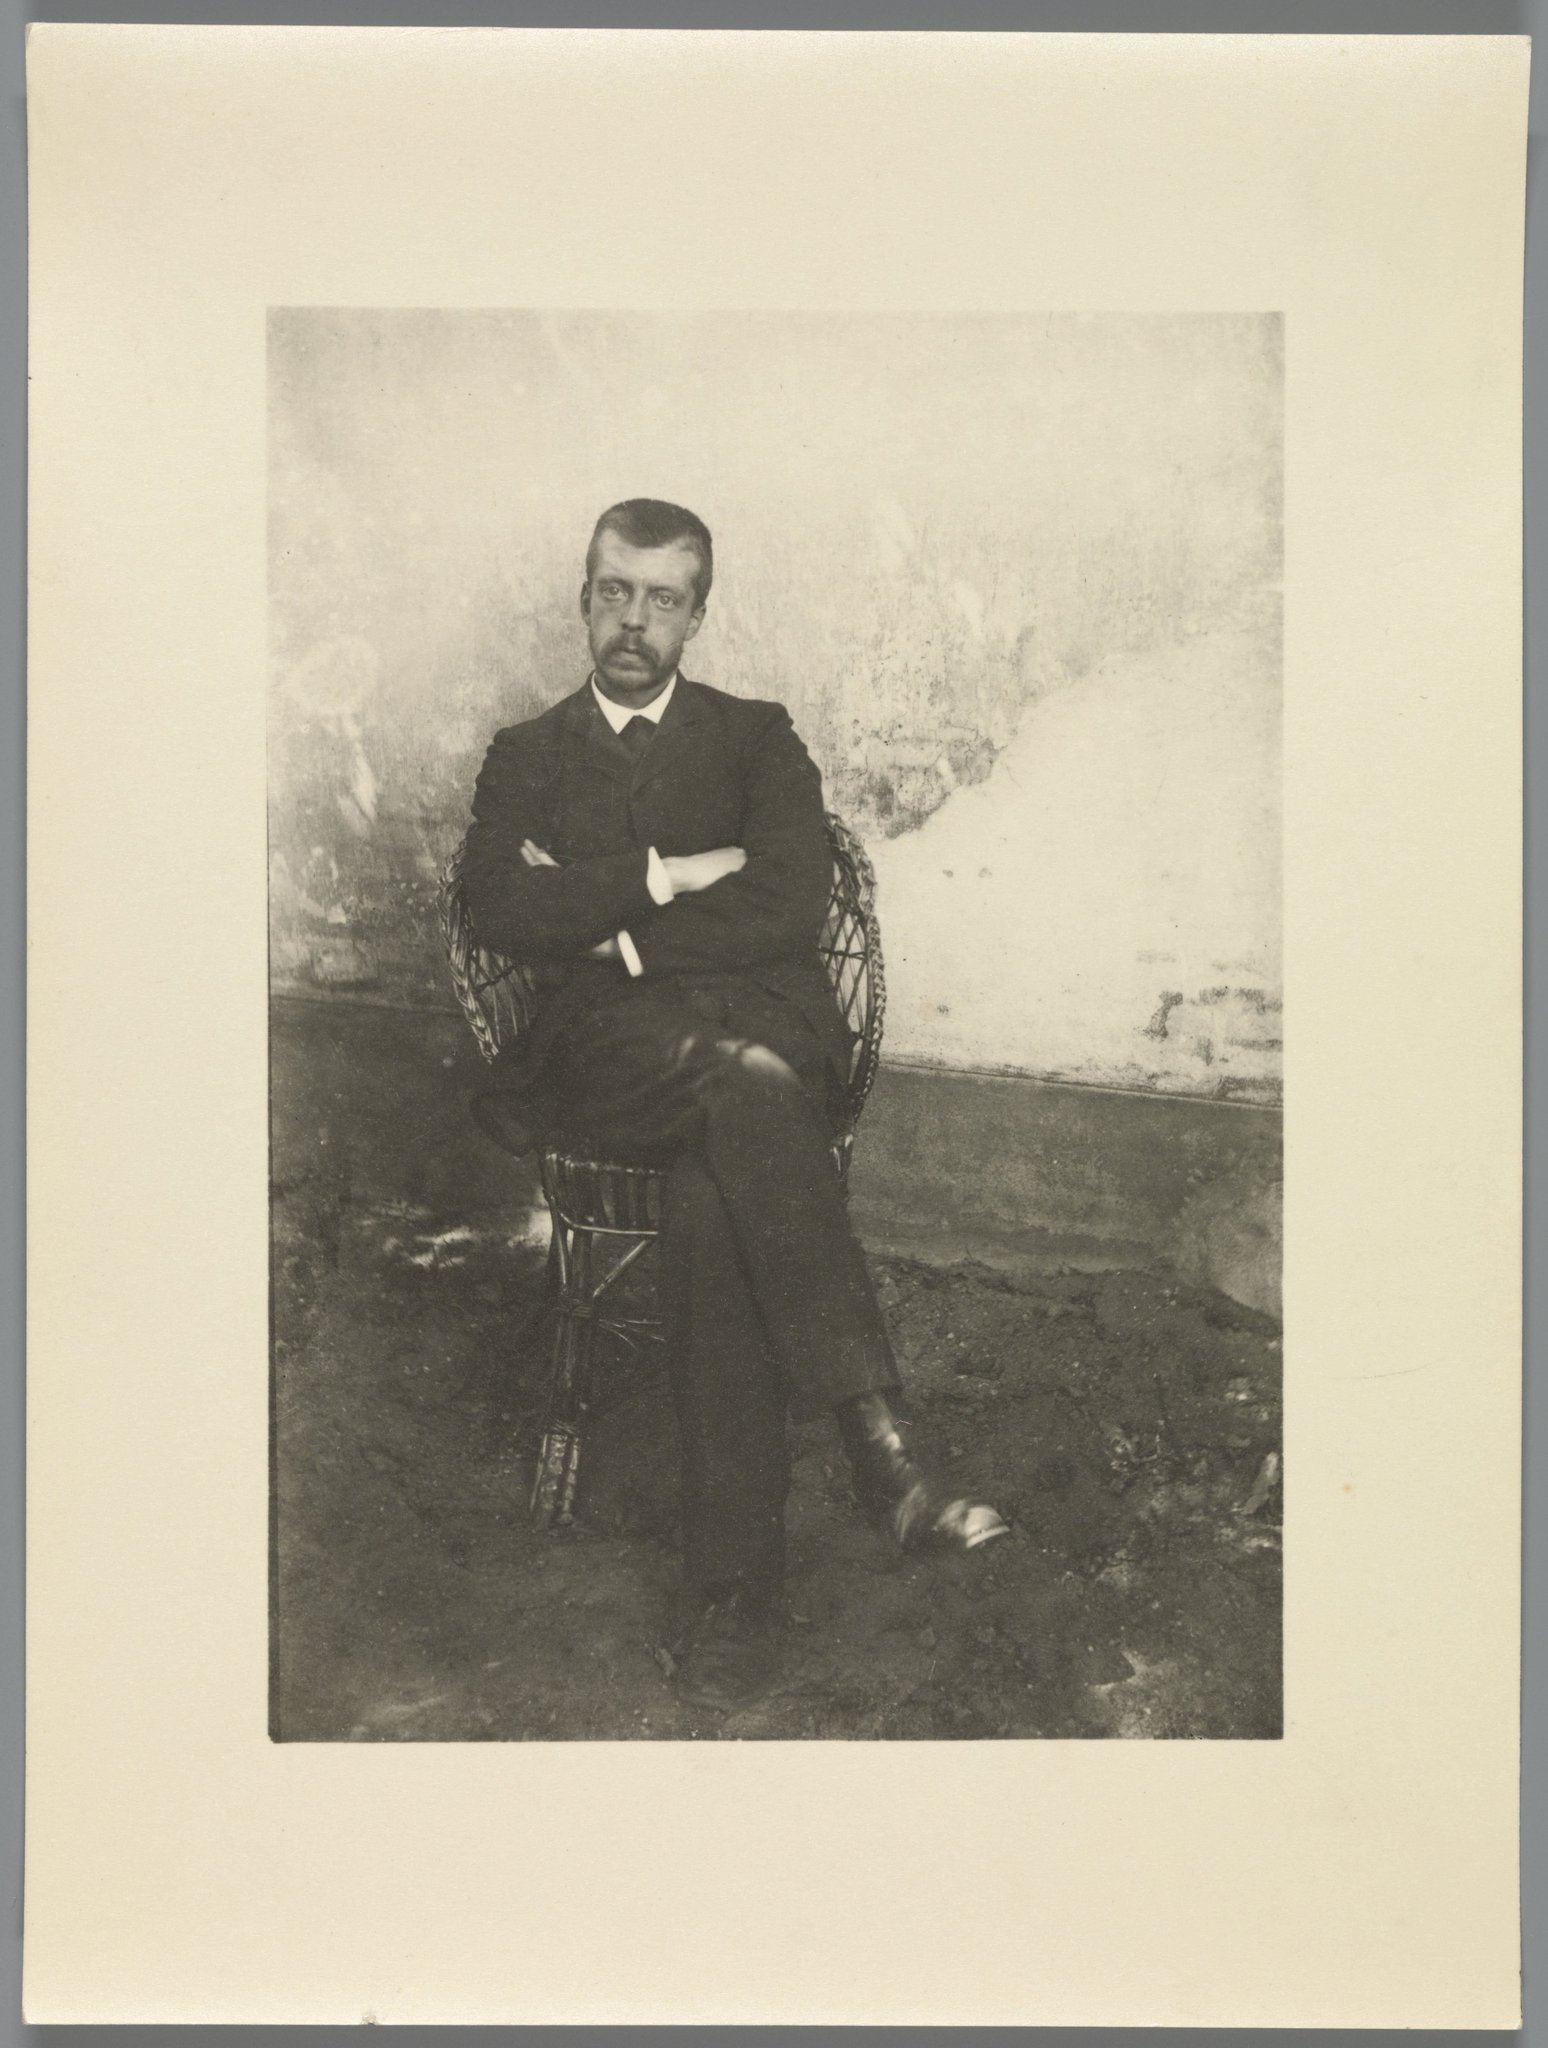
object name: photograph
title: Reproductie naar een foto van Willem Witsen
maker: Anonymous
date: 1860-1915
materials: paper, photographic support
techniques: gelatin silver print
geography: netherlands